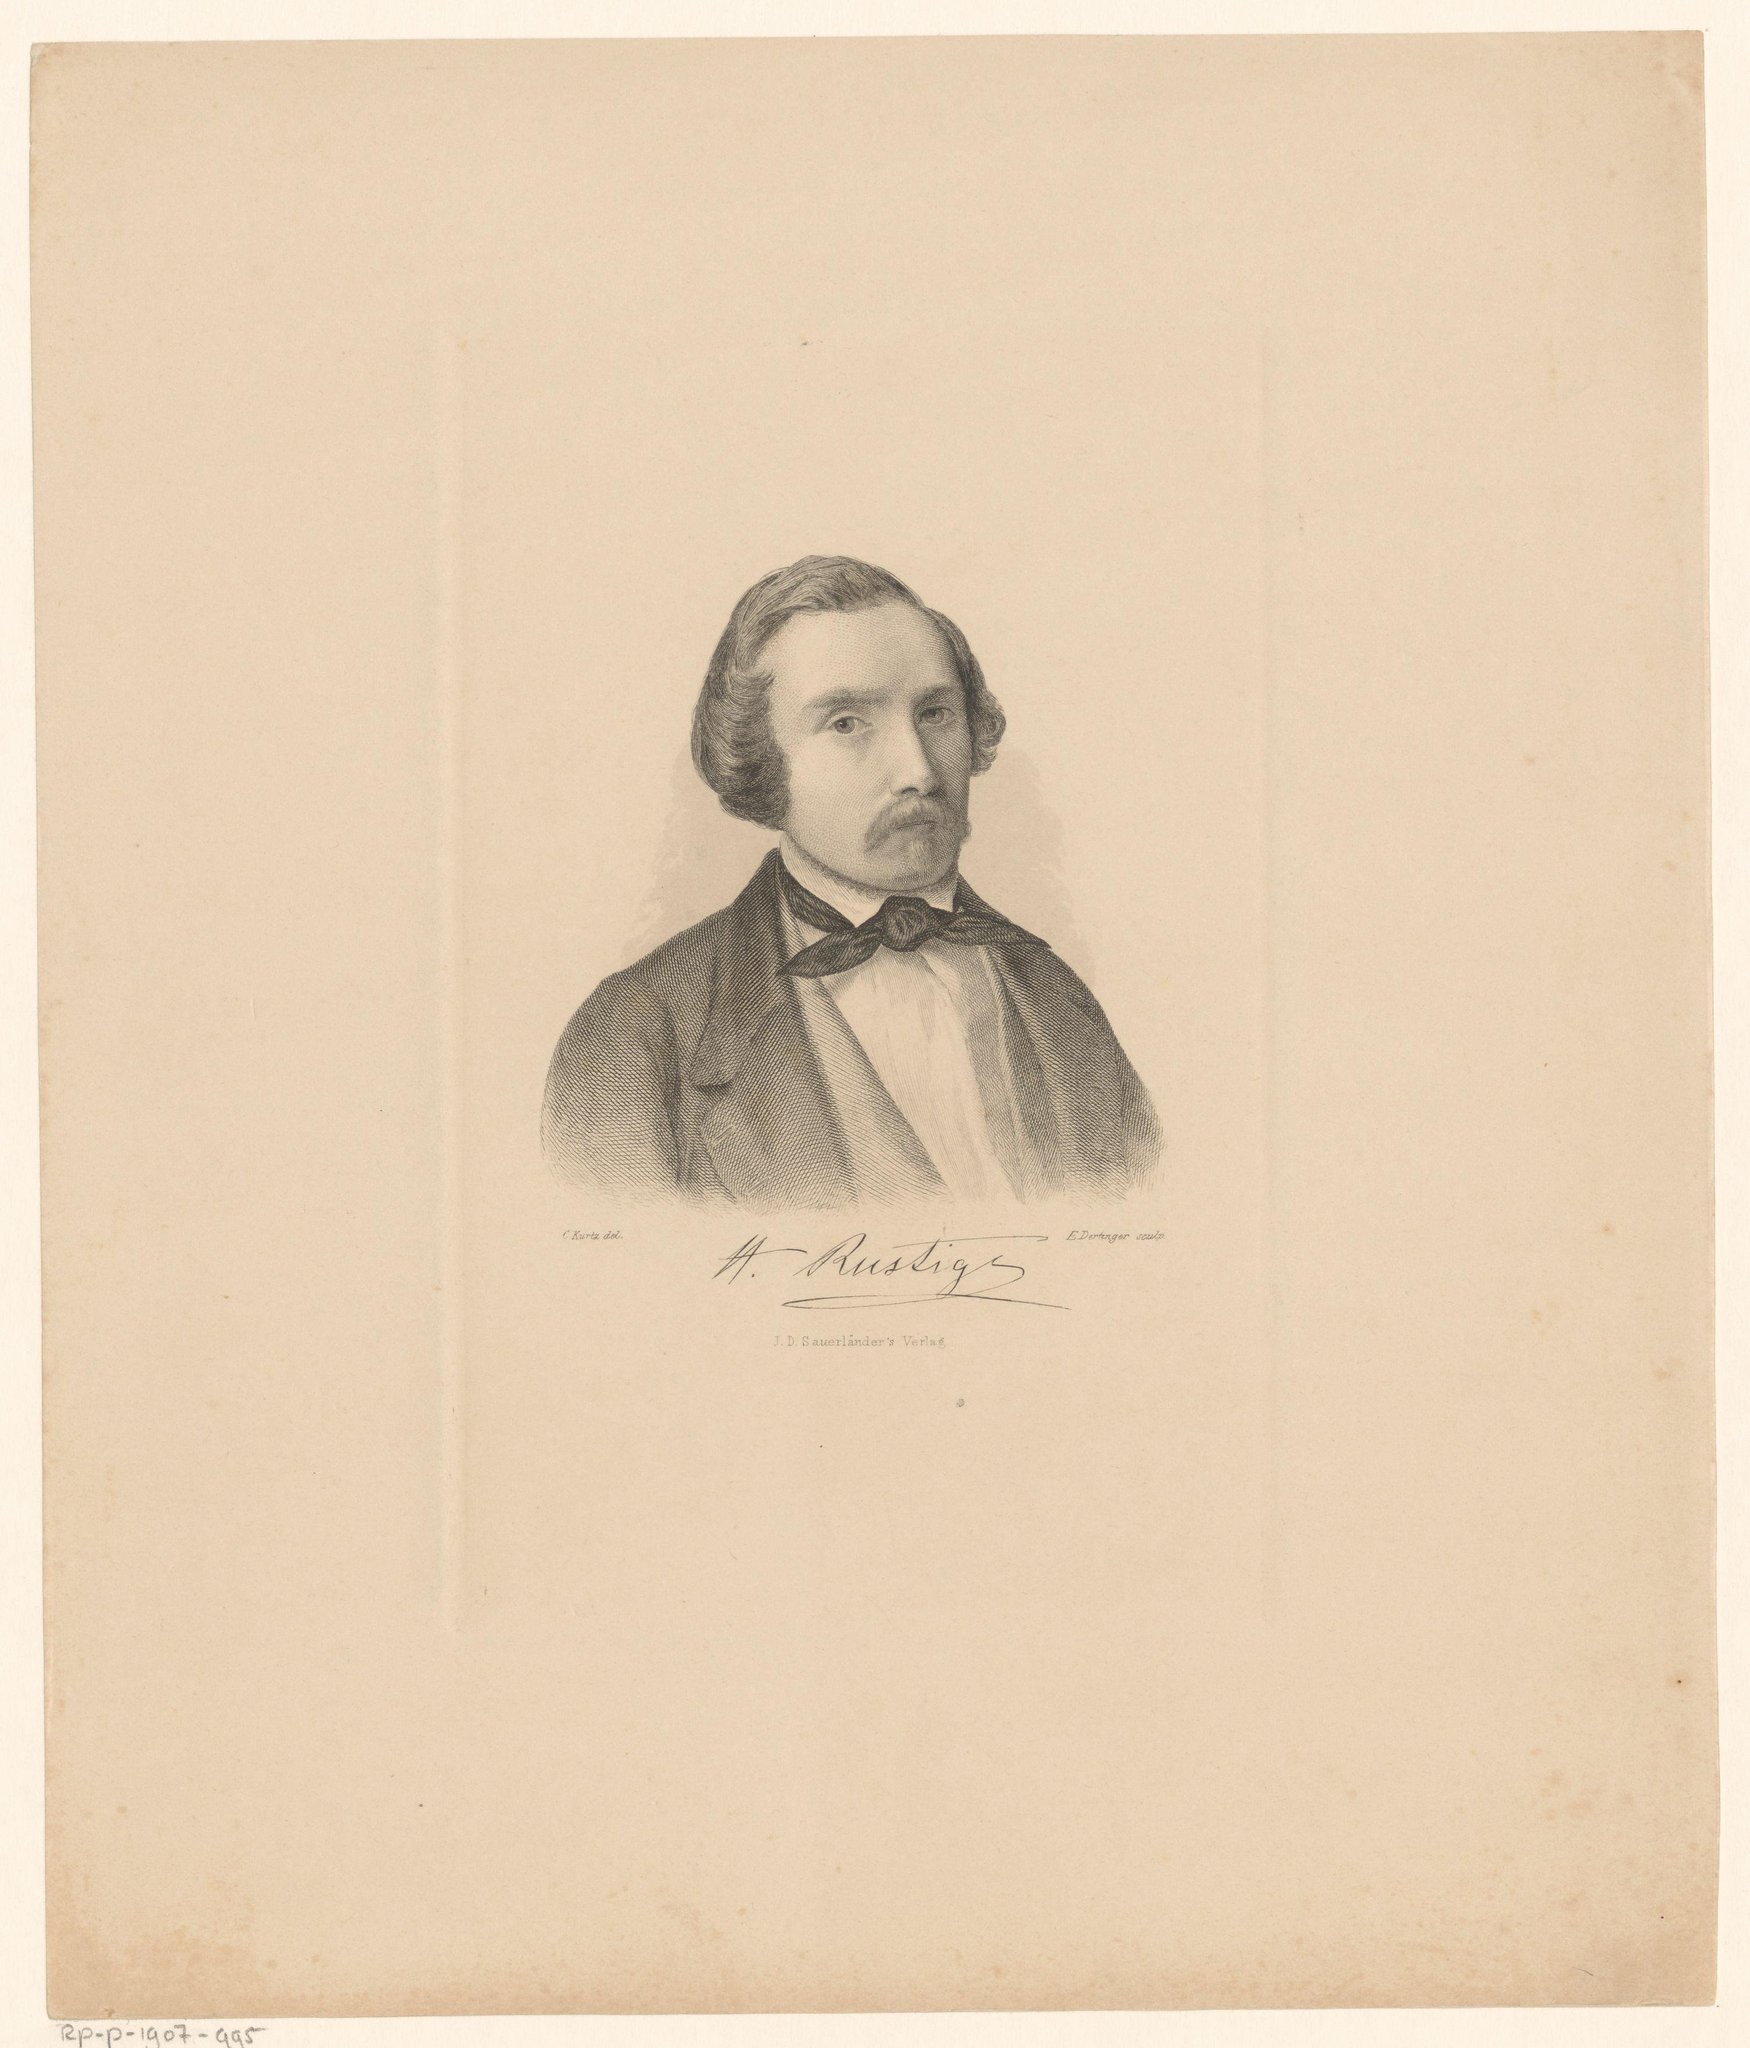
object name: print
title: H. Rustige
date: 1826-1865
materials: paper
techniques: engraving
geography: frankfurt am main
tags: portrait, self-portrait of painter, writer, poet, author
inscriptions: collector's mark: Lugt 2228